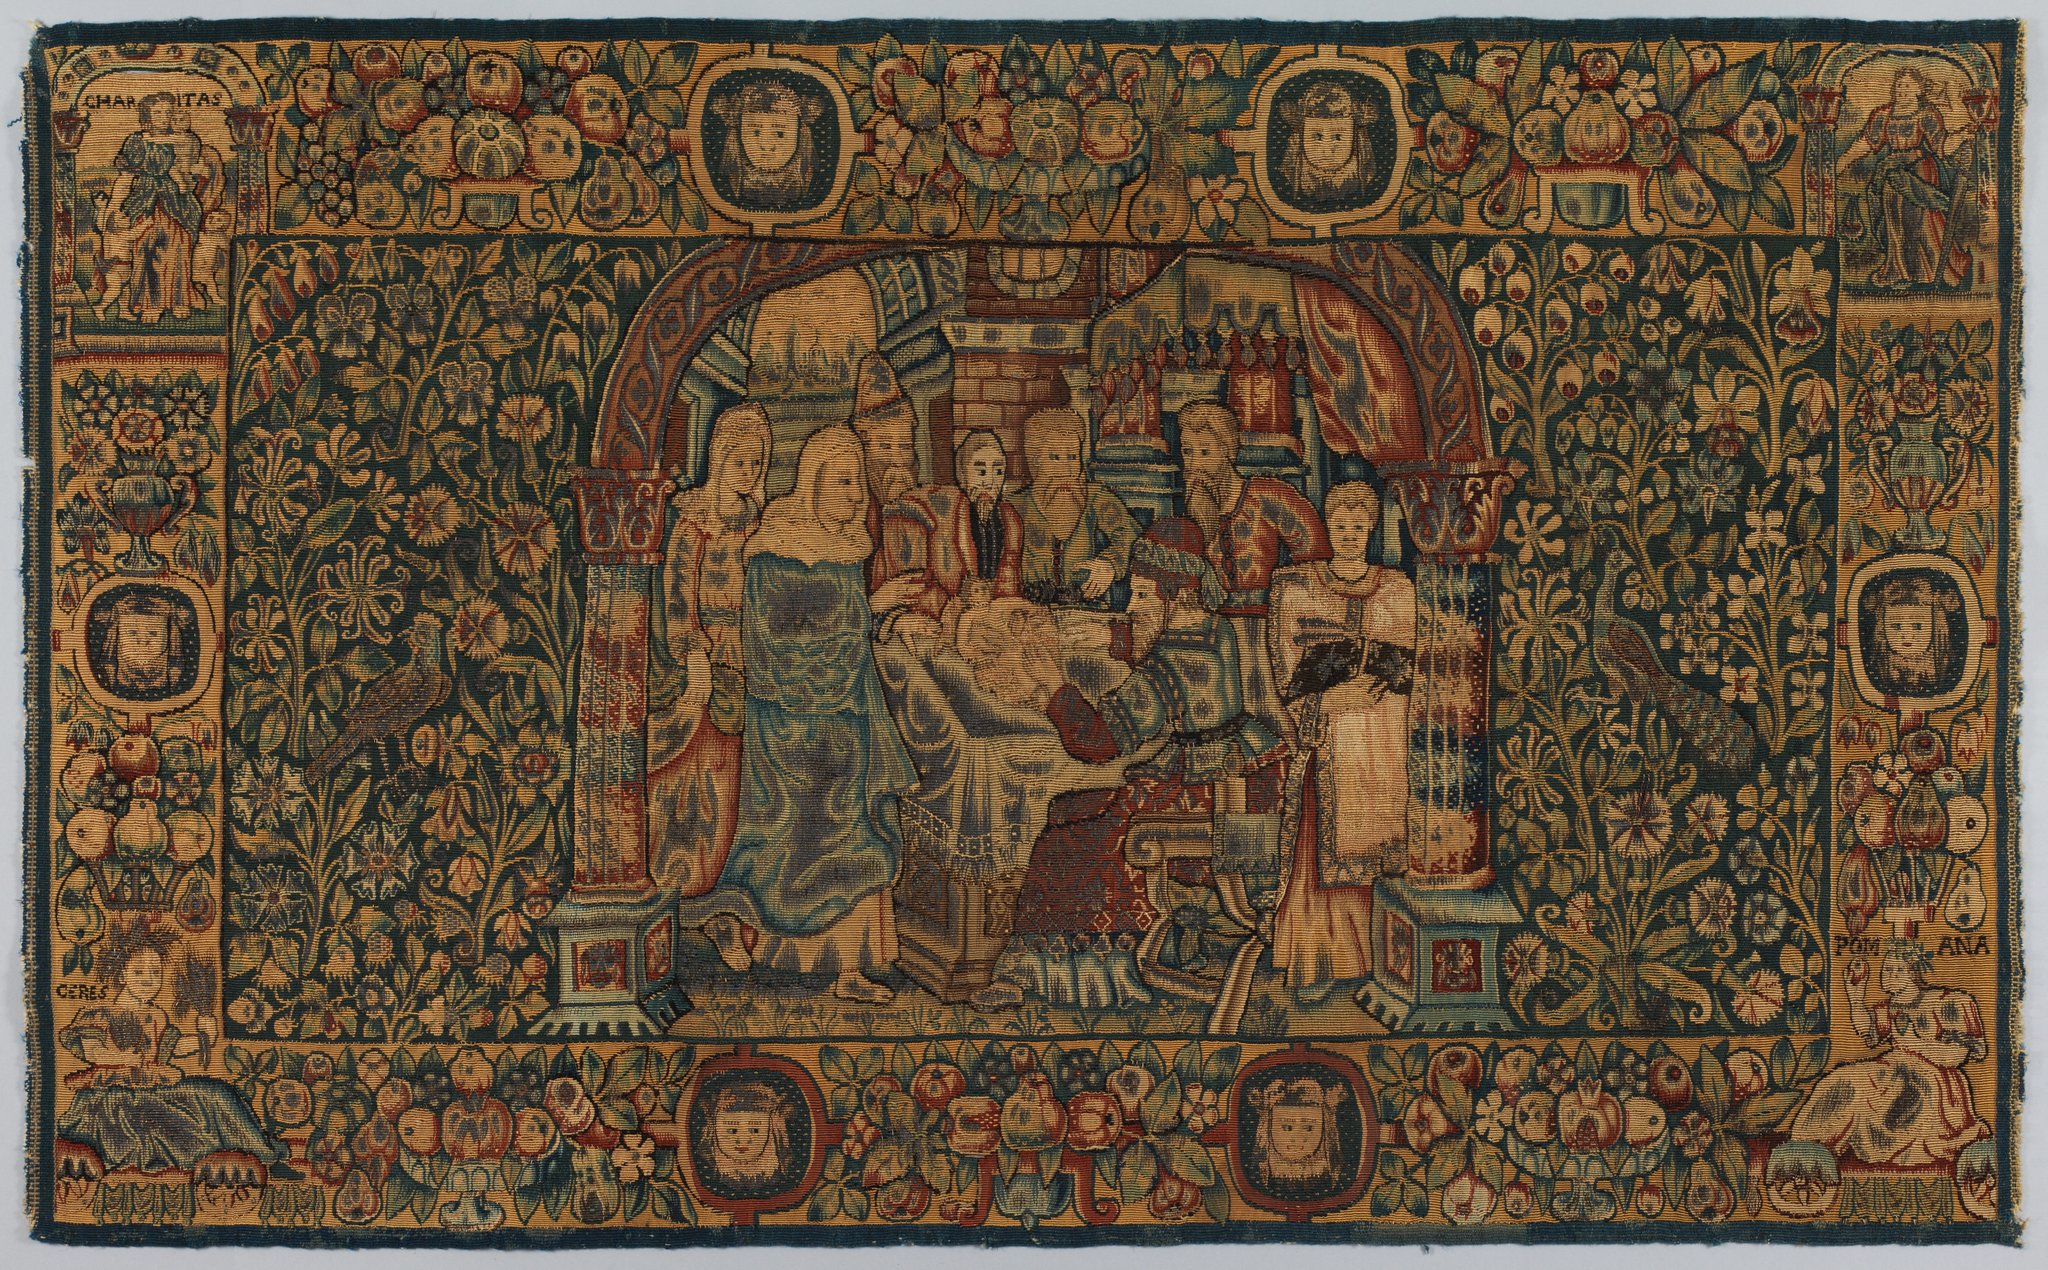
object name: cushion cover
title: The Circumcision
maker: anonymous workshop, british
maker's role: artist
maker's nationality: british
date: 1601-1633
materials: silk, silver, silver gilt, thread, wool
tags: flowers,virgin mary,jesus,circumcision